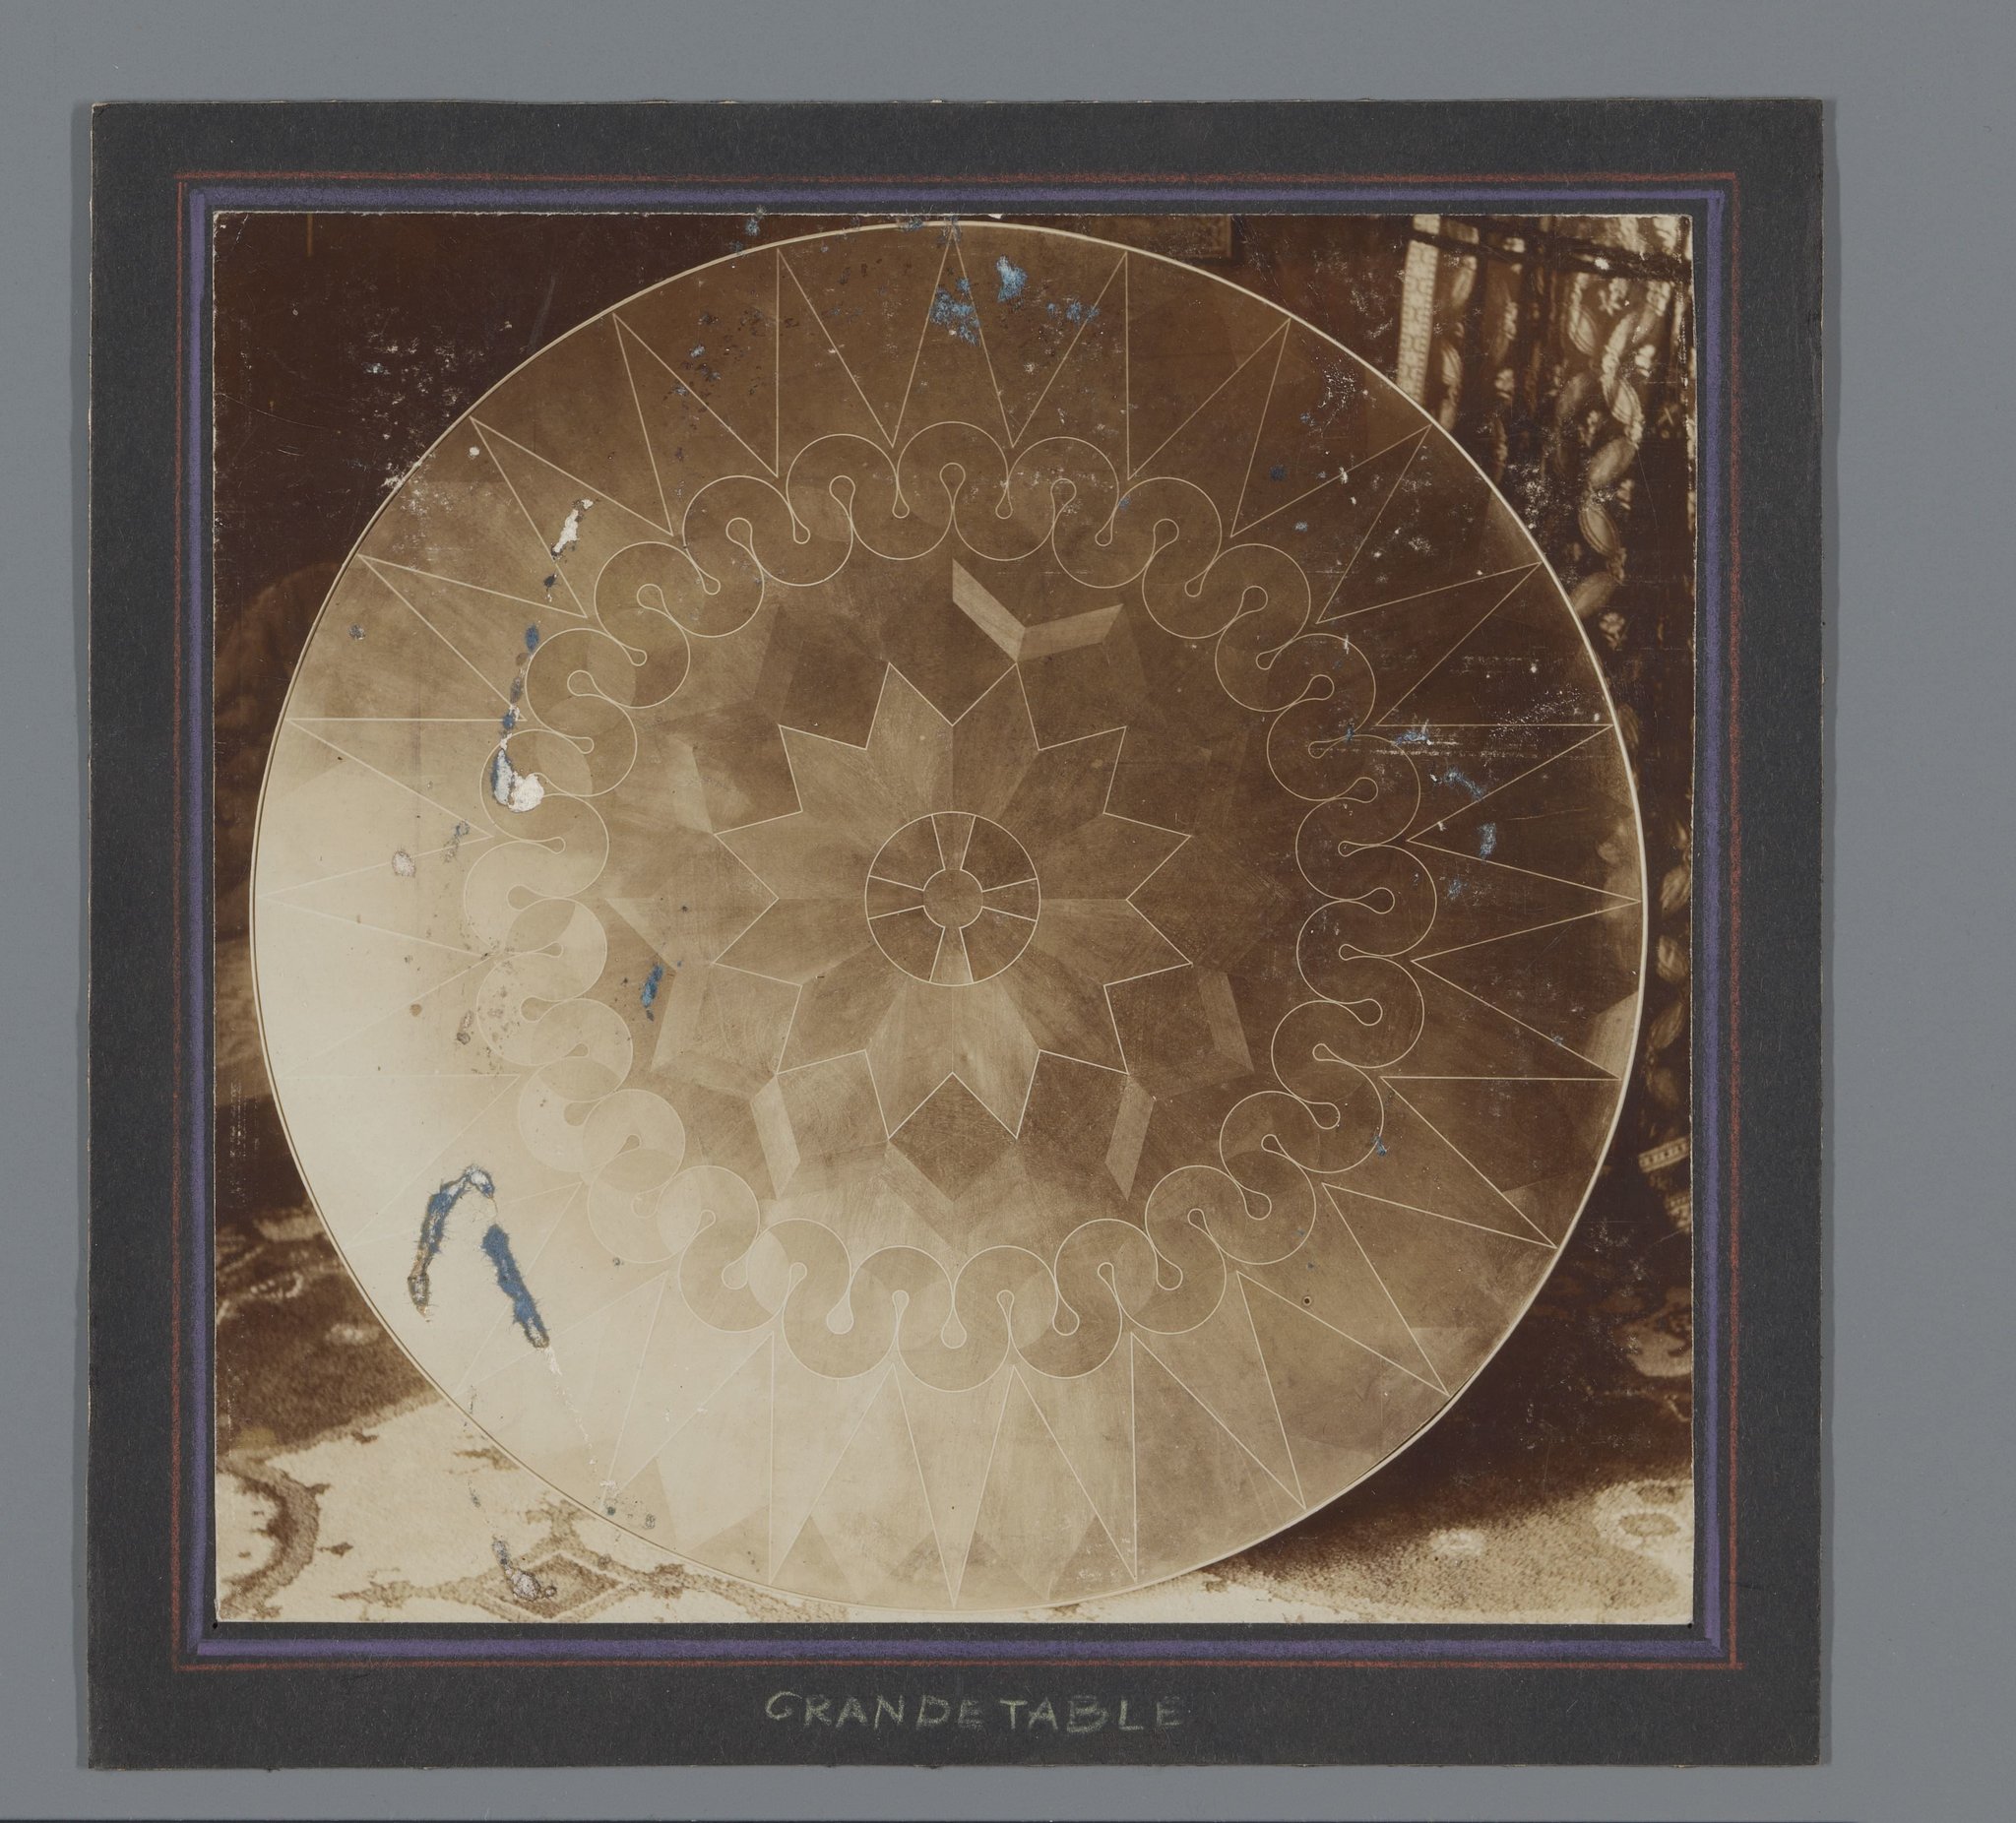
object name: photograph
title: Tafelblad naar ontwerp van Mathieu Lauweriks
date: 1910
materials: cardboard, photographic support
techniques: collodion silver print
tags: table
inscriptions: annotation: ‘GRANDE TABLE’, inscription: ‘salon-ameublement uitgevoerd in cuba-mahoni-/ hout met verguld en geciseleerd koperwerk,/ voor den heer J. P. W. Schuurman, Den Haag./ Ontworpen door J. L. M. Lauweriks, architect./ Uitgevoerd door de firma Wed. C. Nederkoorn,/ meubelmaker te Haarlem. + Beelhouwwerk/ van M. J. Hack te Amsterdam. + Koperwerk van/ F. Zwollo, Amsterdam +++++++++’, annotation: ‘JM Lauweriks-/ Ma[...]ts, 18/ Düsseldorf/ blad der groote tafel’